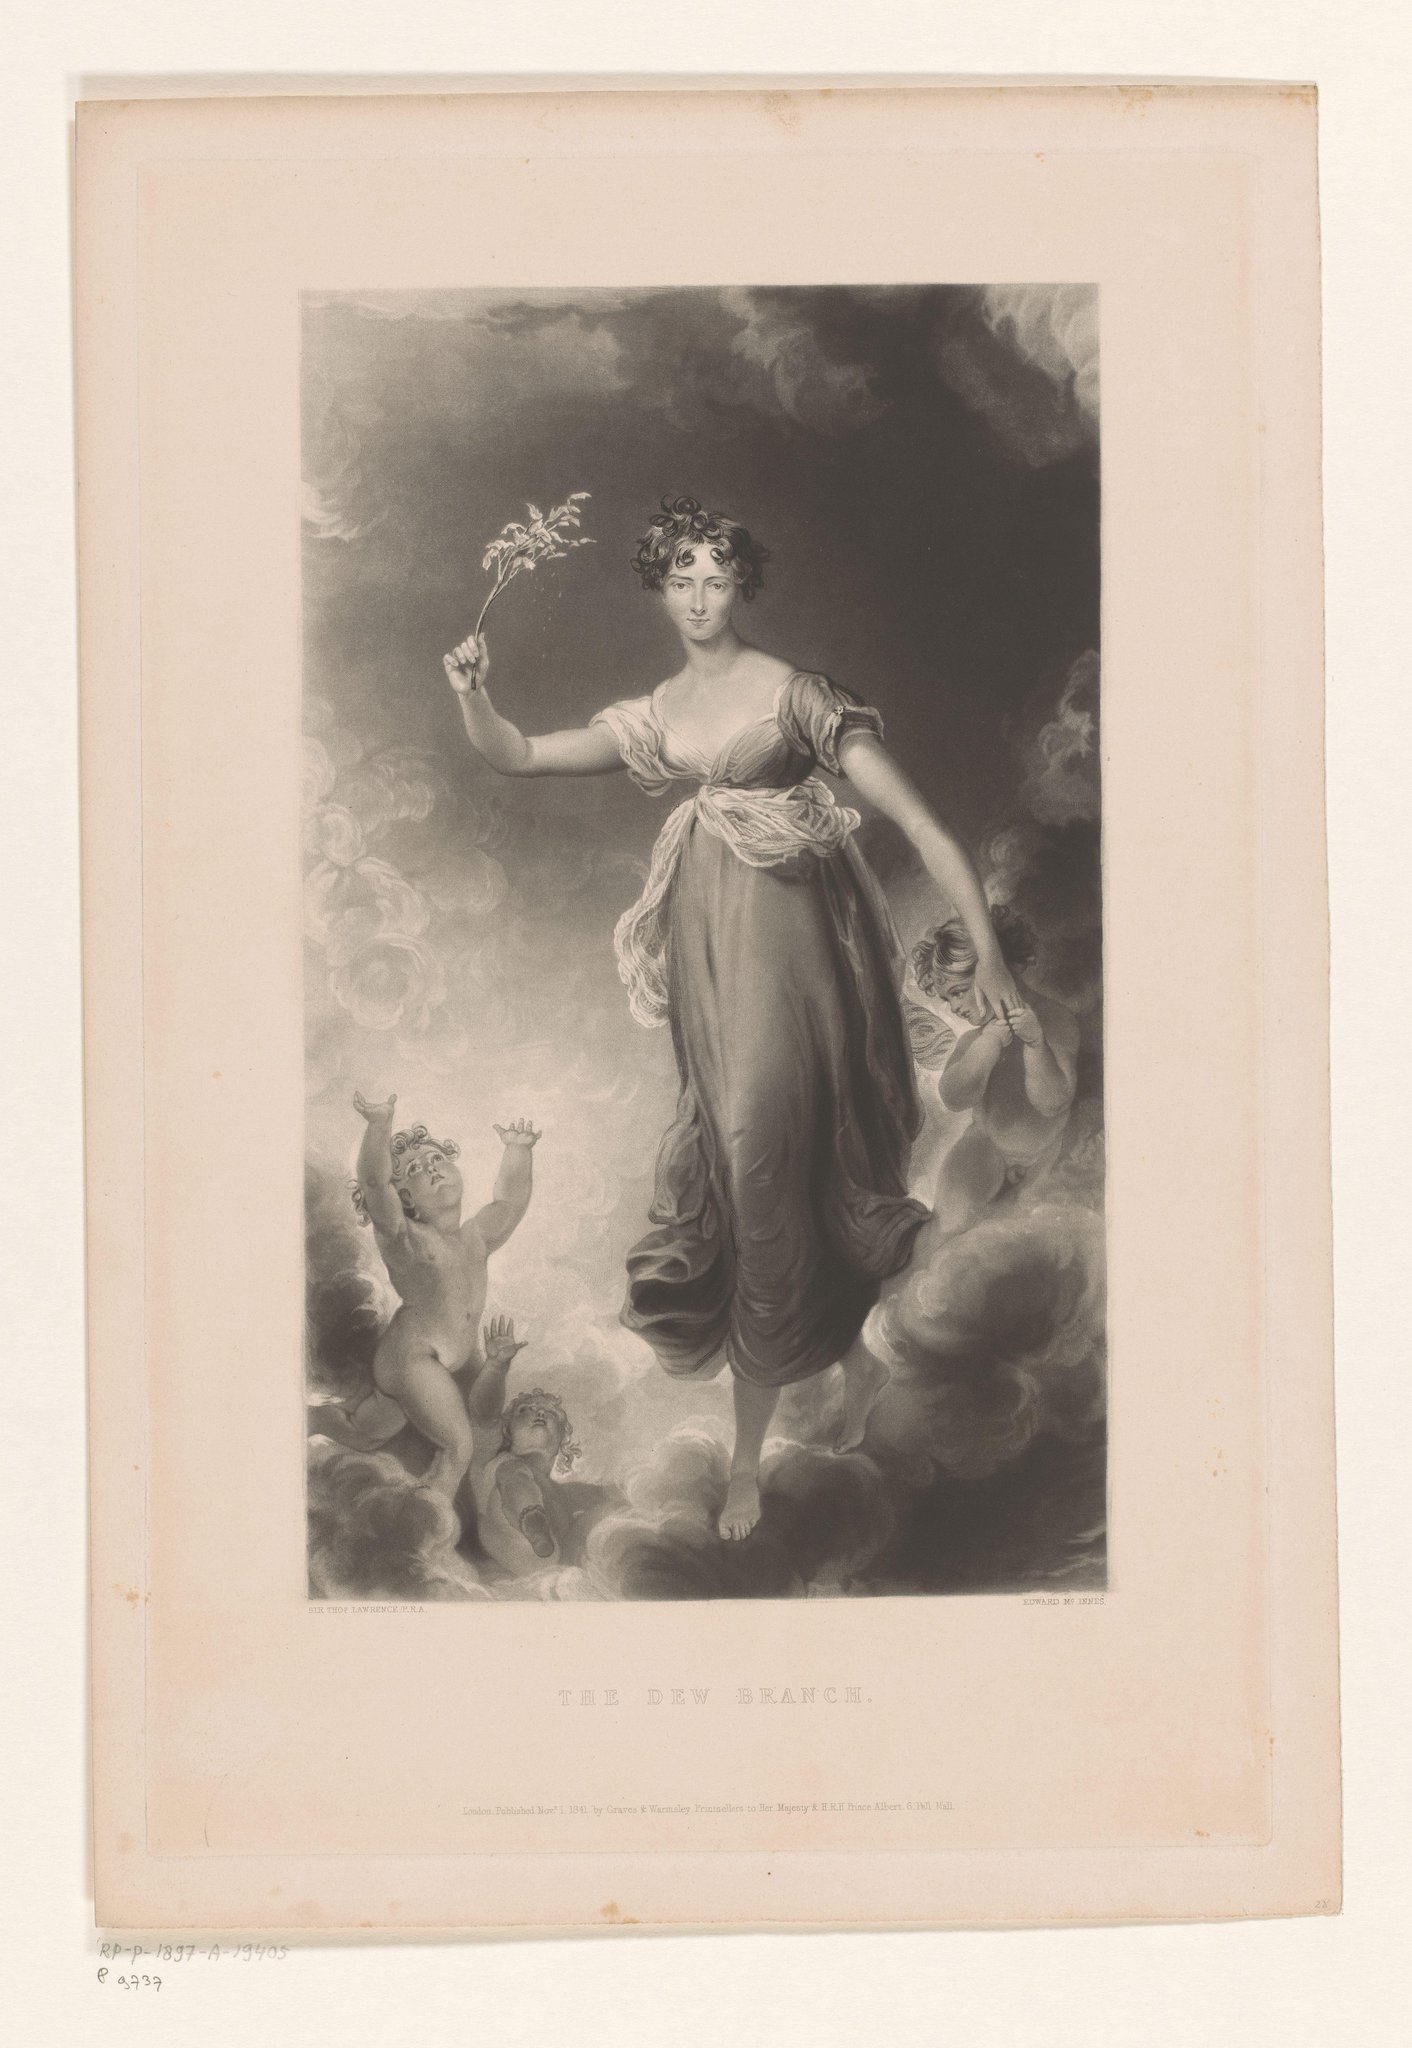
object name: print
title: The Dew Branch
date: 1841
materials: paper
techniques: mezzotint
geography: london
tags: dew, adult woman, representations ~ goddesses, demi-goddesses, heroines, etc. (non-christian religions), cupids: 'amores', 'amoretti', 'putti'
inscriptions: collector's mark: Lugt 2228